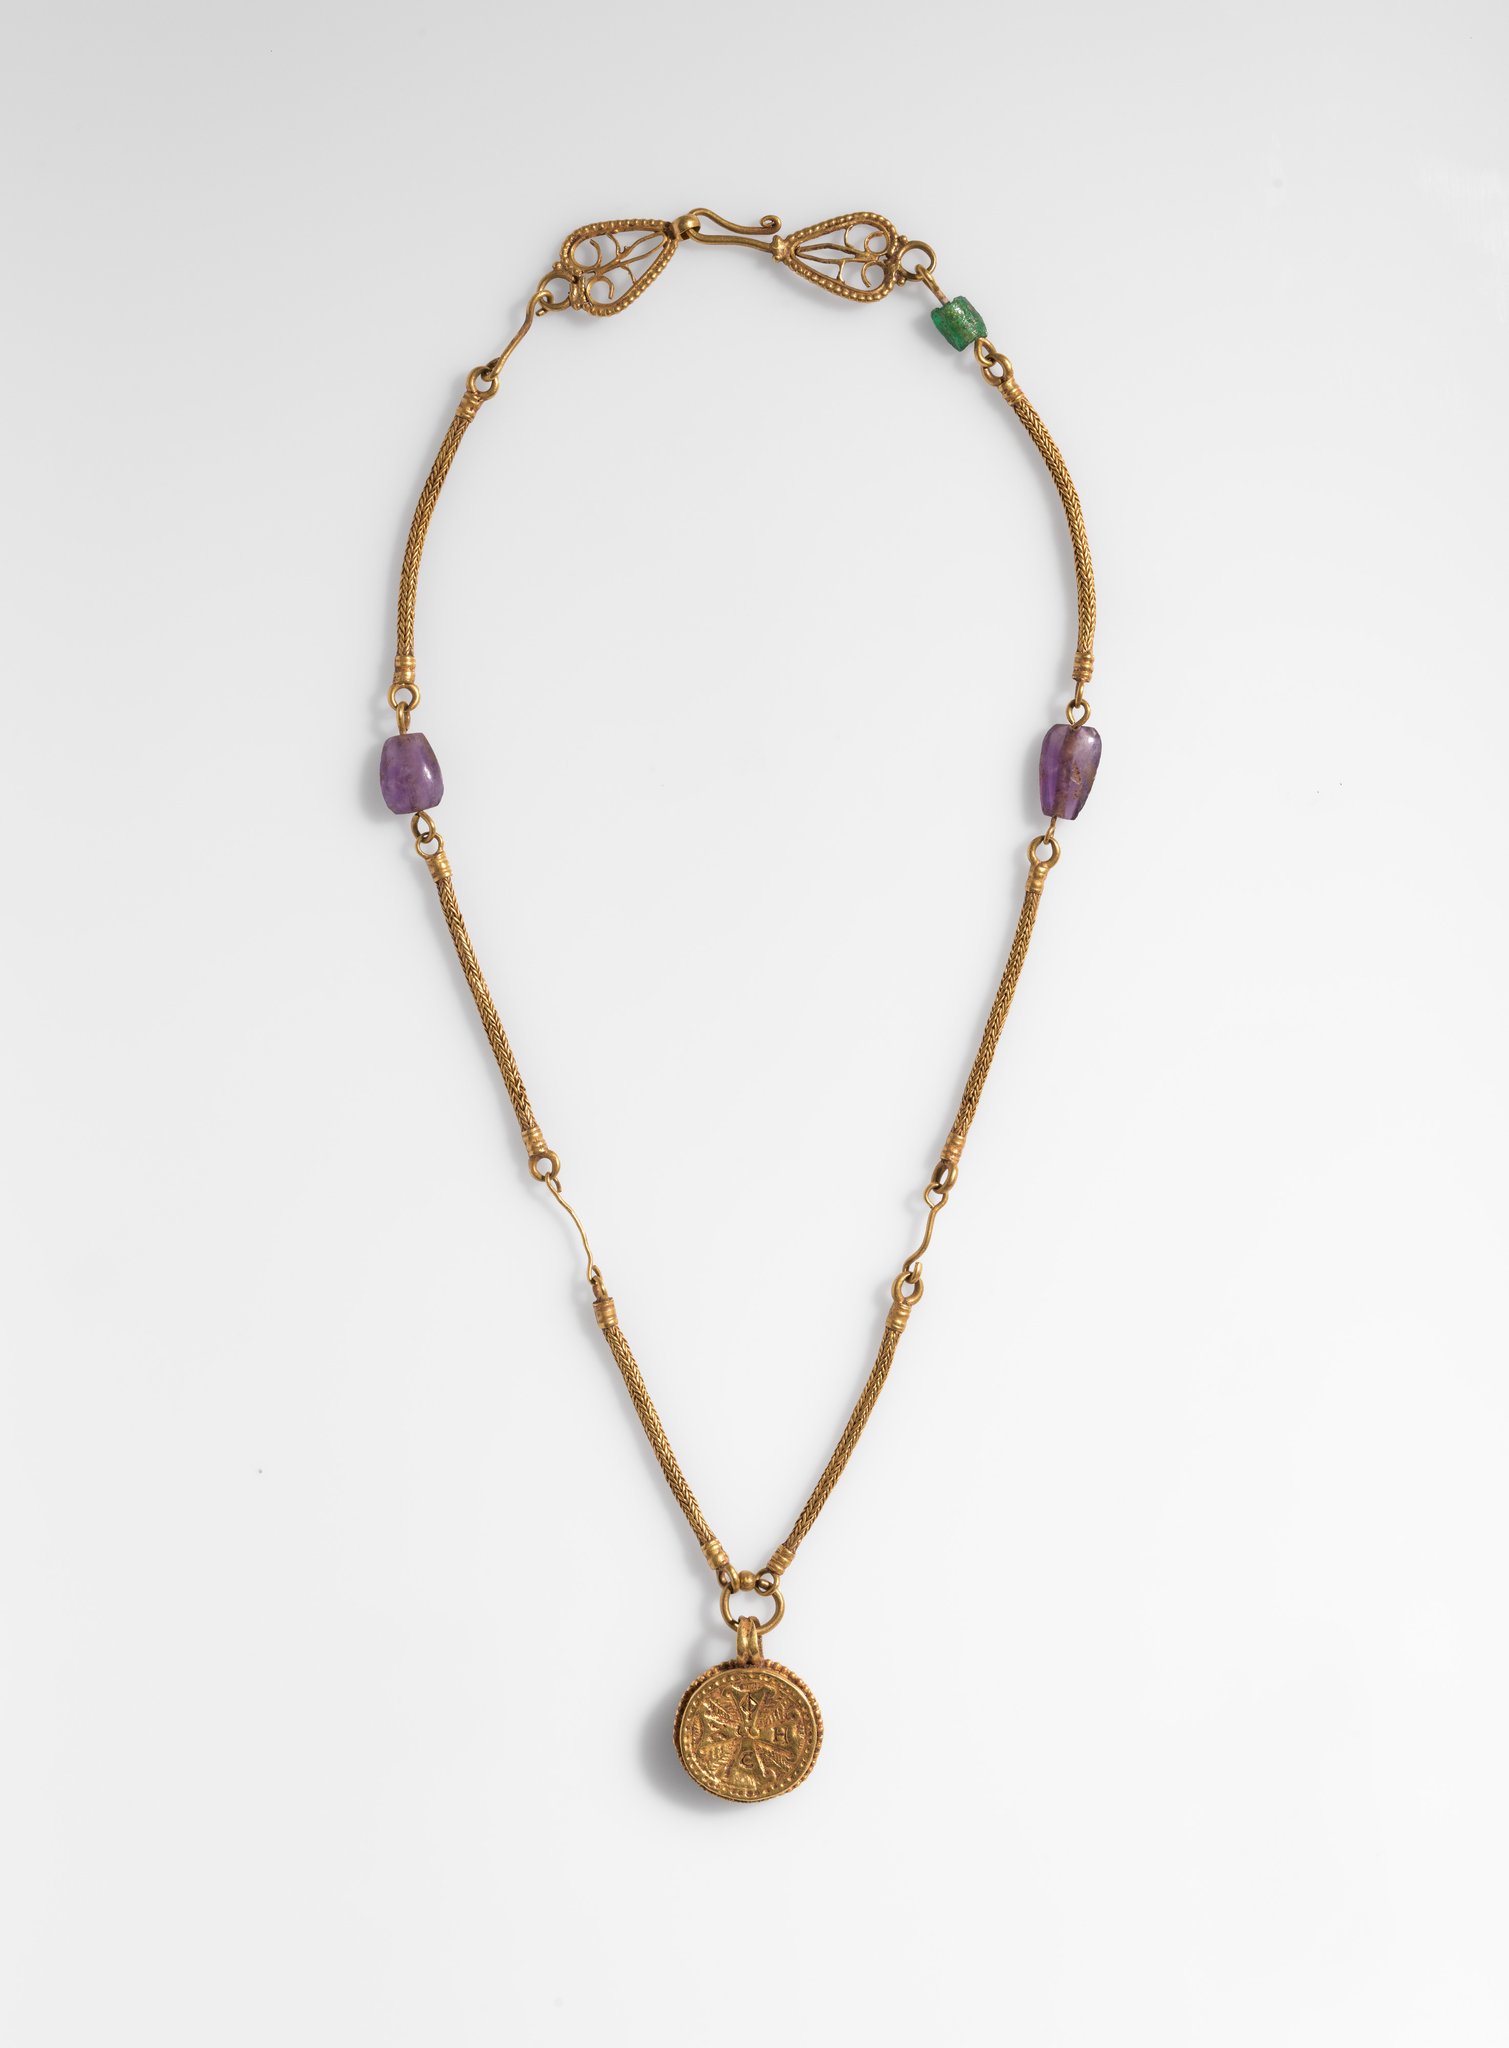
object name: necklace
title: Gold Necklace with Gold Cross, Two Amethysts, and an Emerald Plasma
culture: byzantine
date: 501-700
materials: gemstone, gold